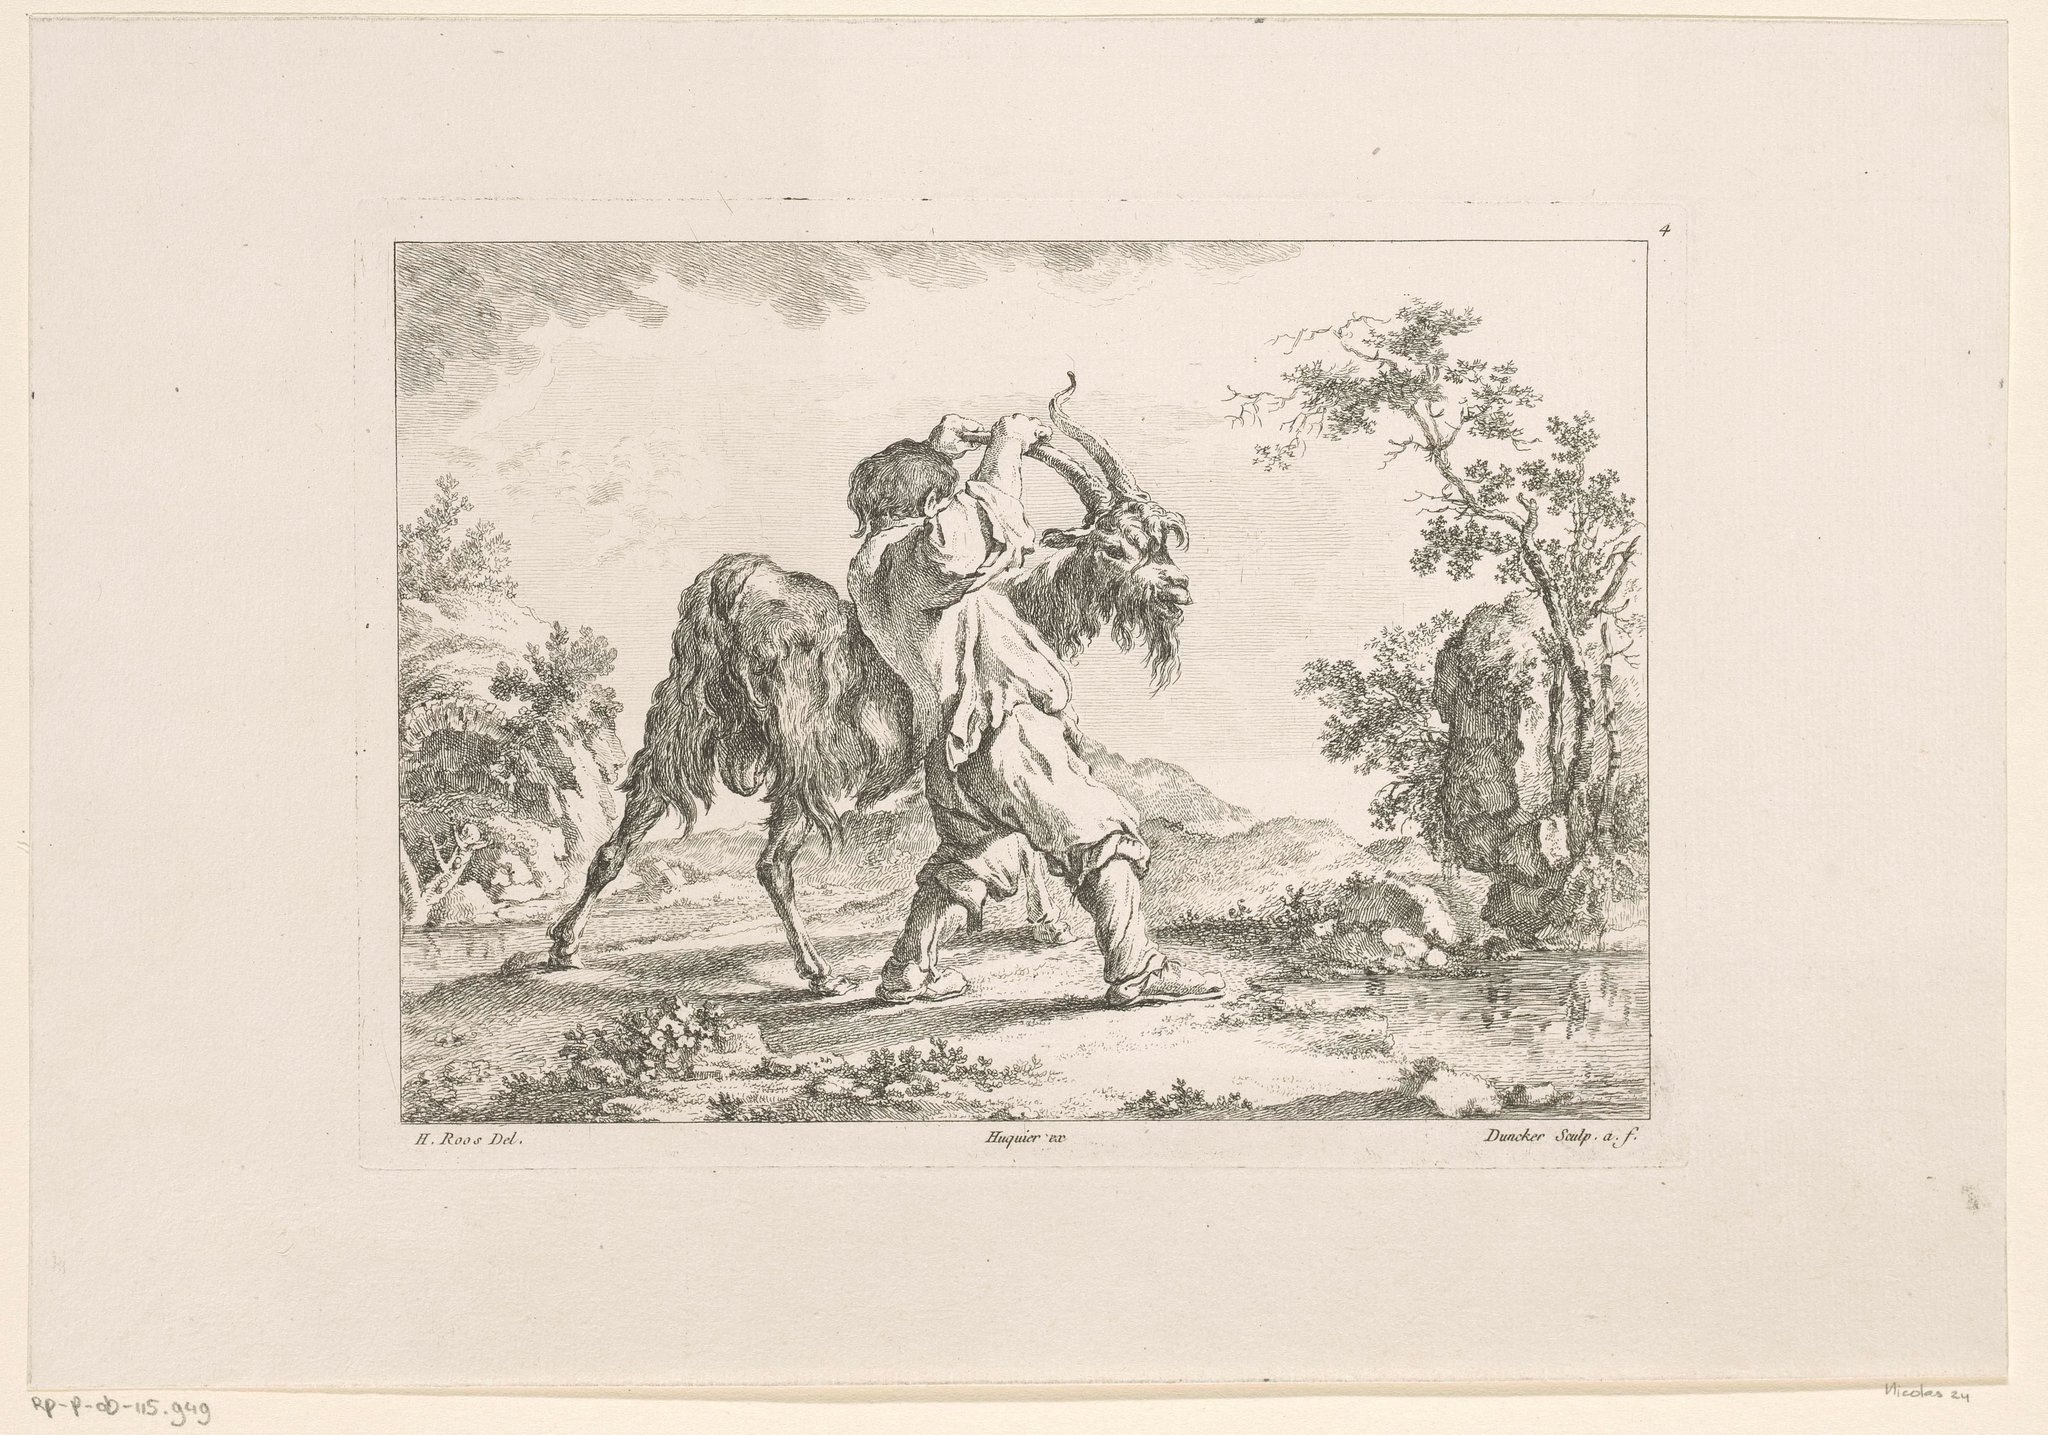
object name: print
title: Livre de differents Sujets de Figures et Animaux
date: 1769-1772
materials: paper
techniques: etching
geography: paris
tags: child, he-goat, billy-goat, catching animals, landscapes - hh - ideal landscapes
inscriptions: collector's mark: Lugt 240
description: Onderdeel van een serie van acht prenten.